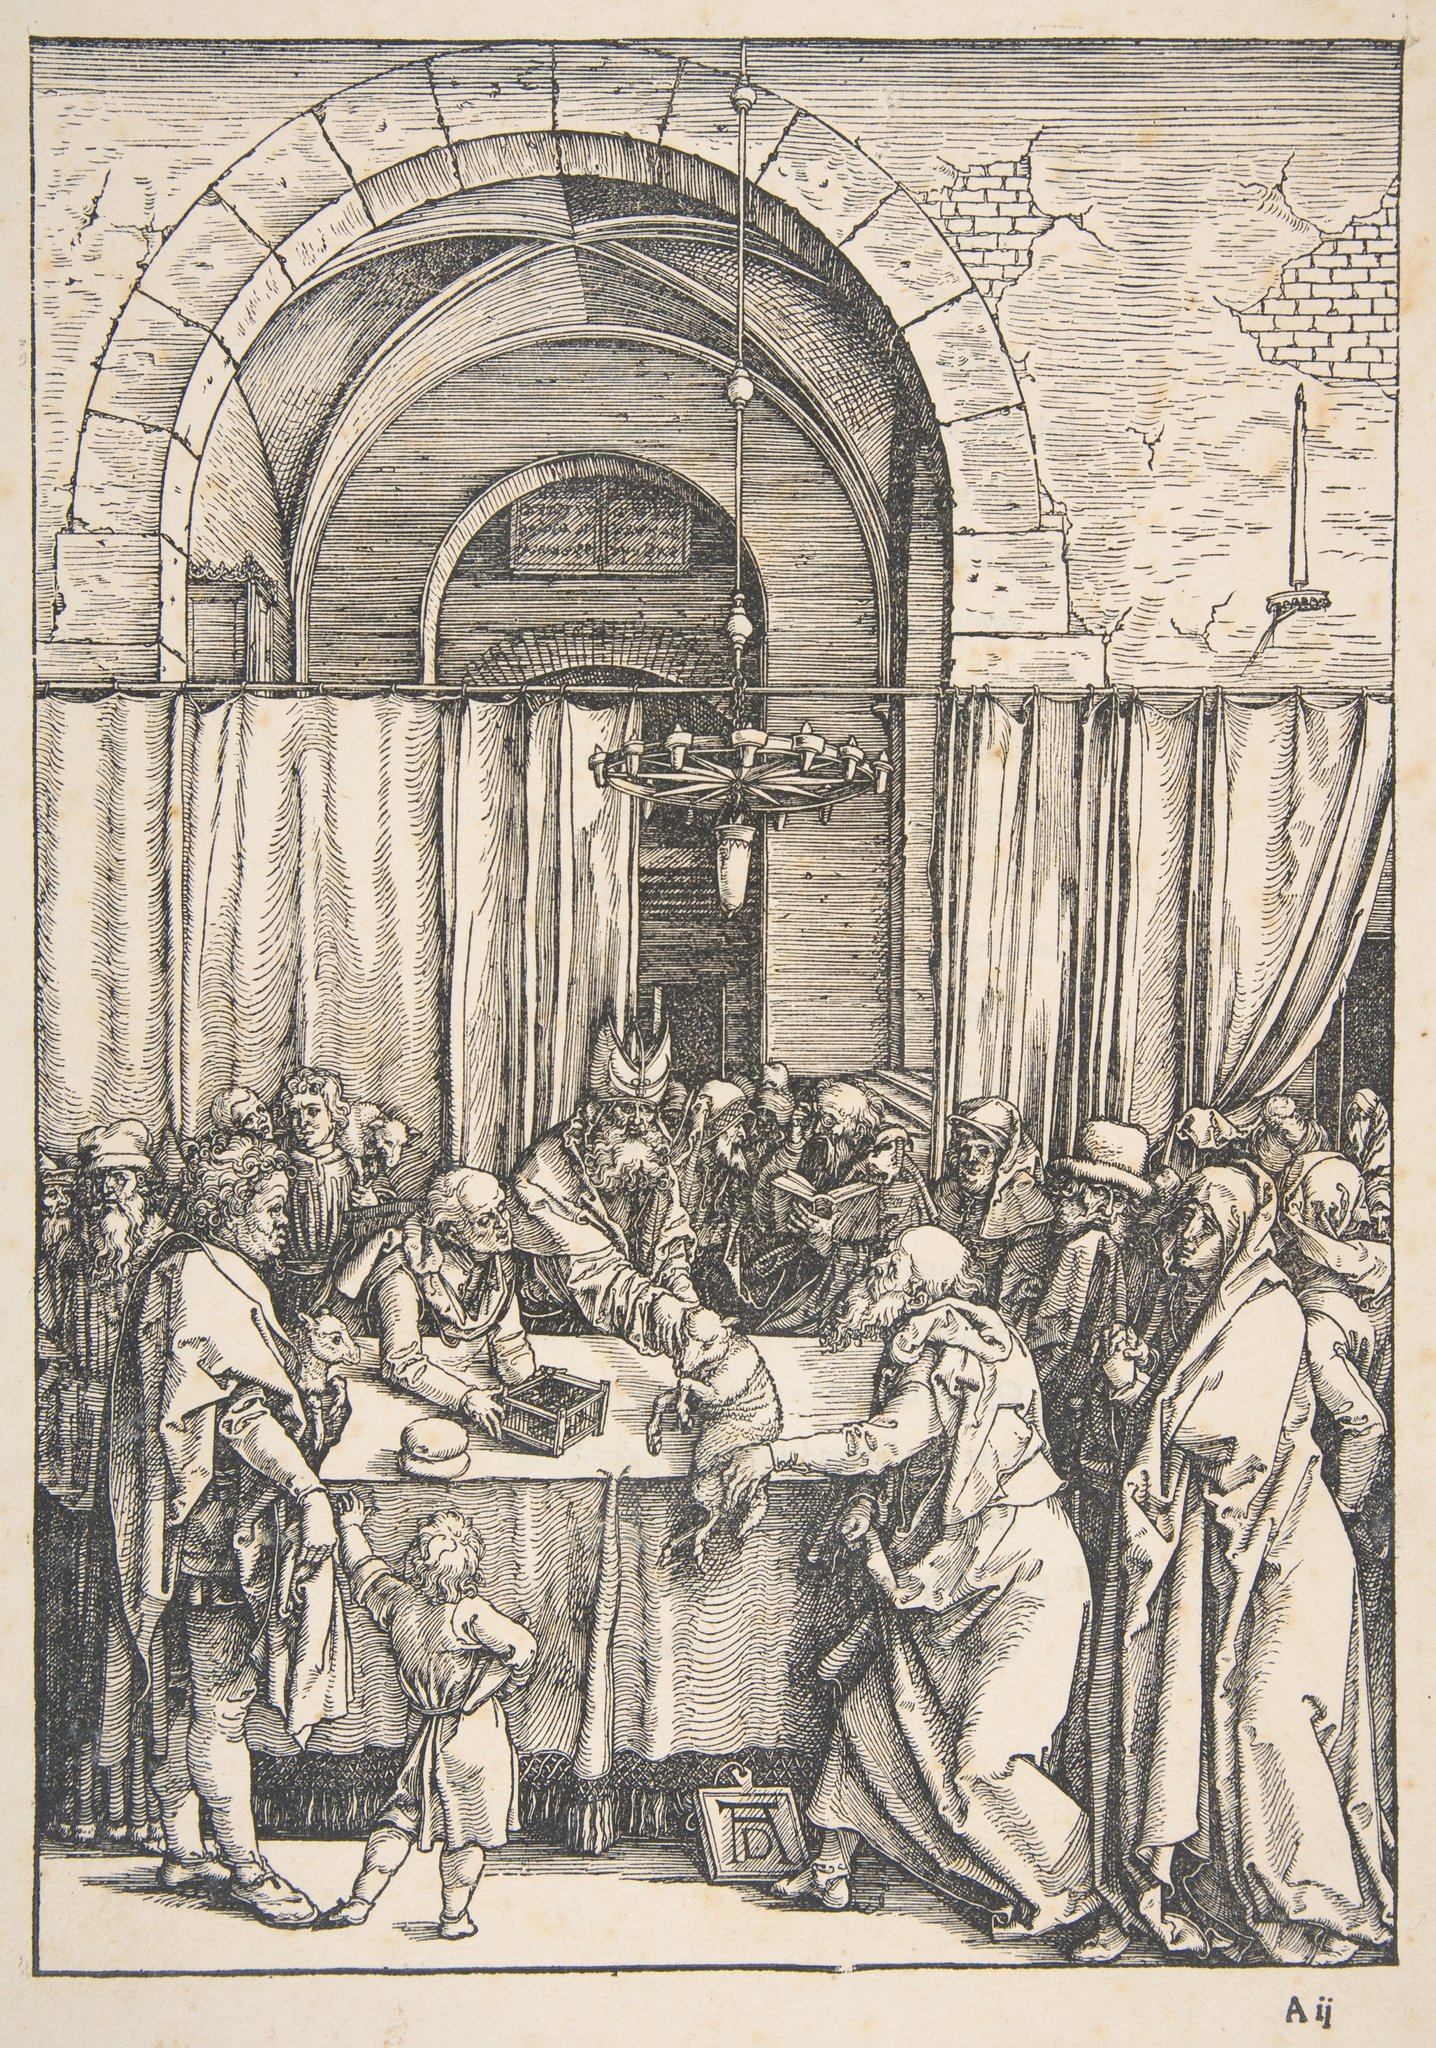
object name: print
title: The Rejection of Joachim's Offering, from "The Life of the Virgin"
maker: albrecht dürer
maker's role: artist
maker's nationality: german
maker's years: 1471-1528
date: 1504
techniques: woodcut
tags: men,women,sheep,saints